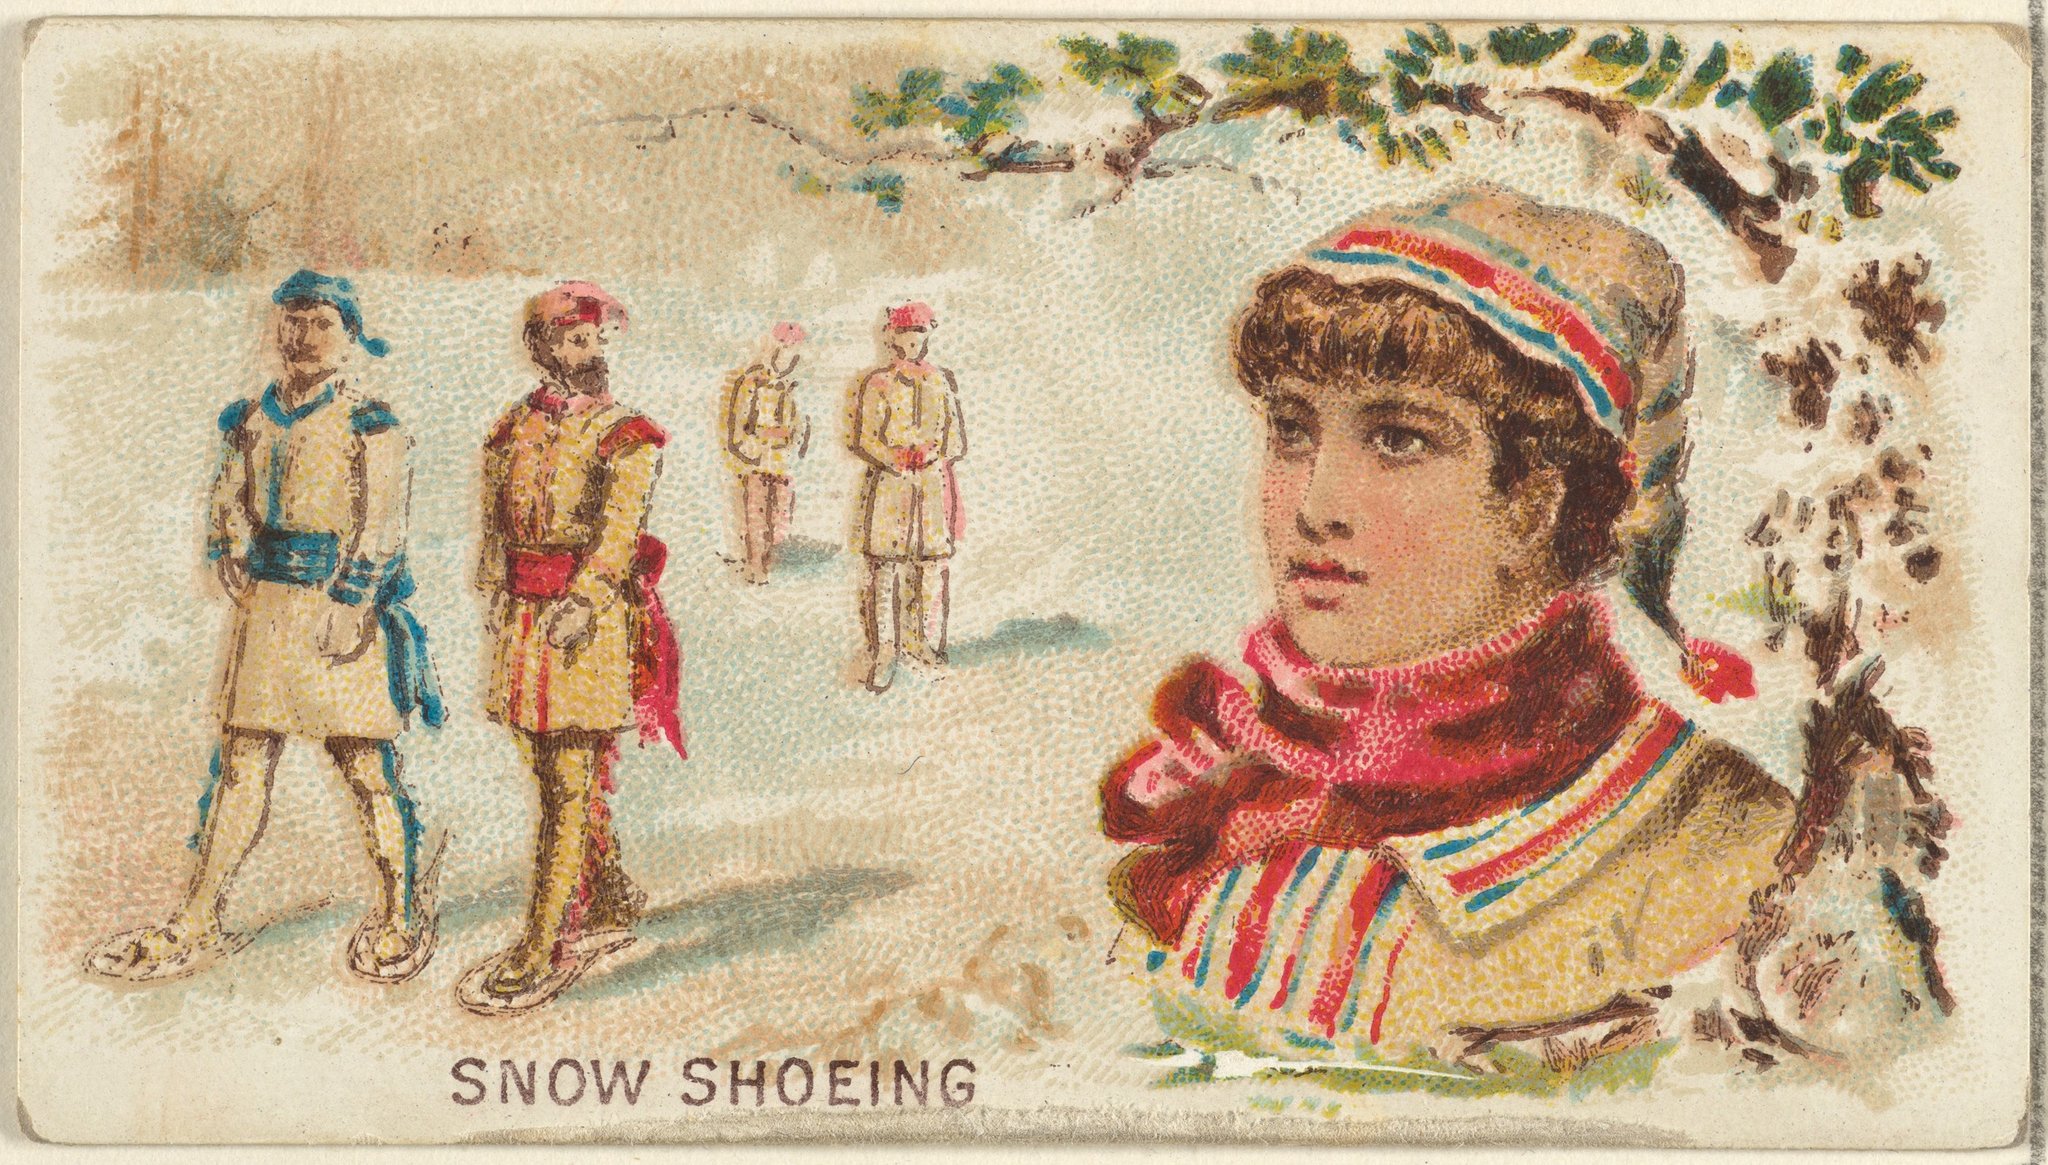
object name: print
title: Snowshoeing, from the Games and Sports series (N165) for Old Judge Cigarettes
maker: goodwin & company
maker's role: publisher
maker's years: 1850-1950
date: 1889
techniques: color lithograph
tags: men